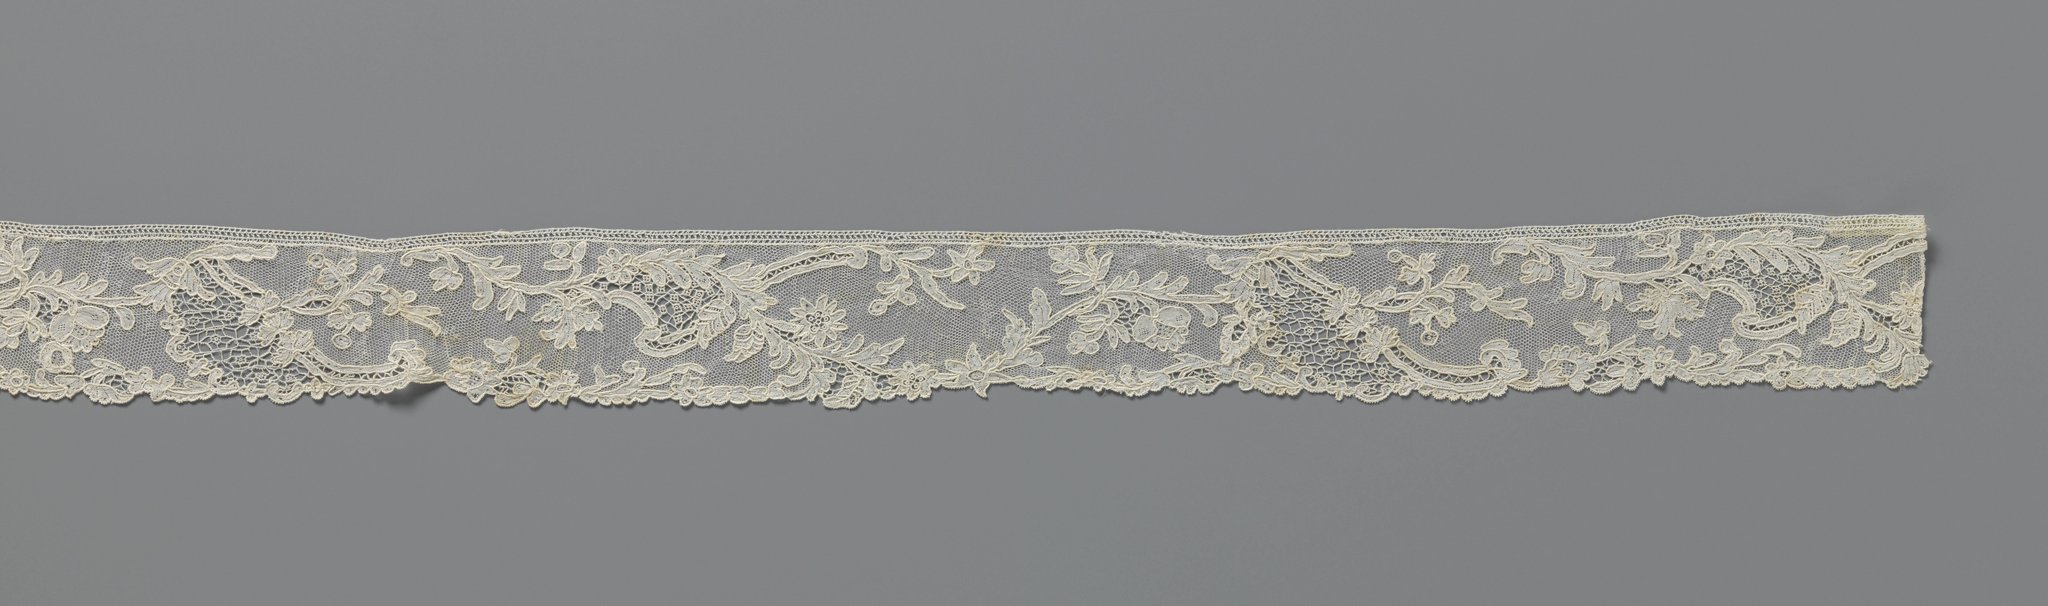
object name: strip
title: Strook naaldkant met halve ovalen bekroond met een narcis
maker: Anonymous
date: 1750-1770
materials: linen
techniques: lace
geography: france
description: Strook naturelkleurige naaldkant: Alençon-kant. Patroon met een repetitief motief van verschillende ranken met veelsoortige bloemen op een fijne zeshoekige maasgrond. Tussen de ranken opengewerkte figuren, waaronder halve ovalen. De halve ovalen zijn gevuld met een siergrond met zespuntige bloemen, ze beslaan de hele breedte van de strook en worden bekroond door een narcis. De geschulpte onderrand vormt zich deels vanuit het rankenpatroon en verder vanuit smalle liggende bladranken met enkele bloemen. De bovenzijde is afgezet met een rand kloskant.